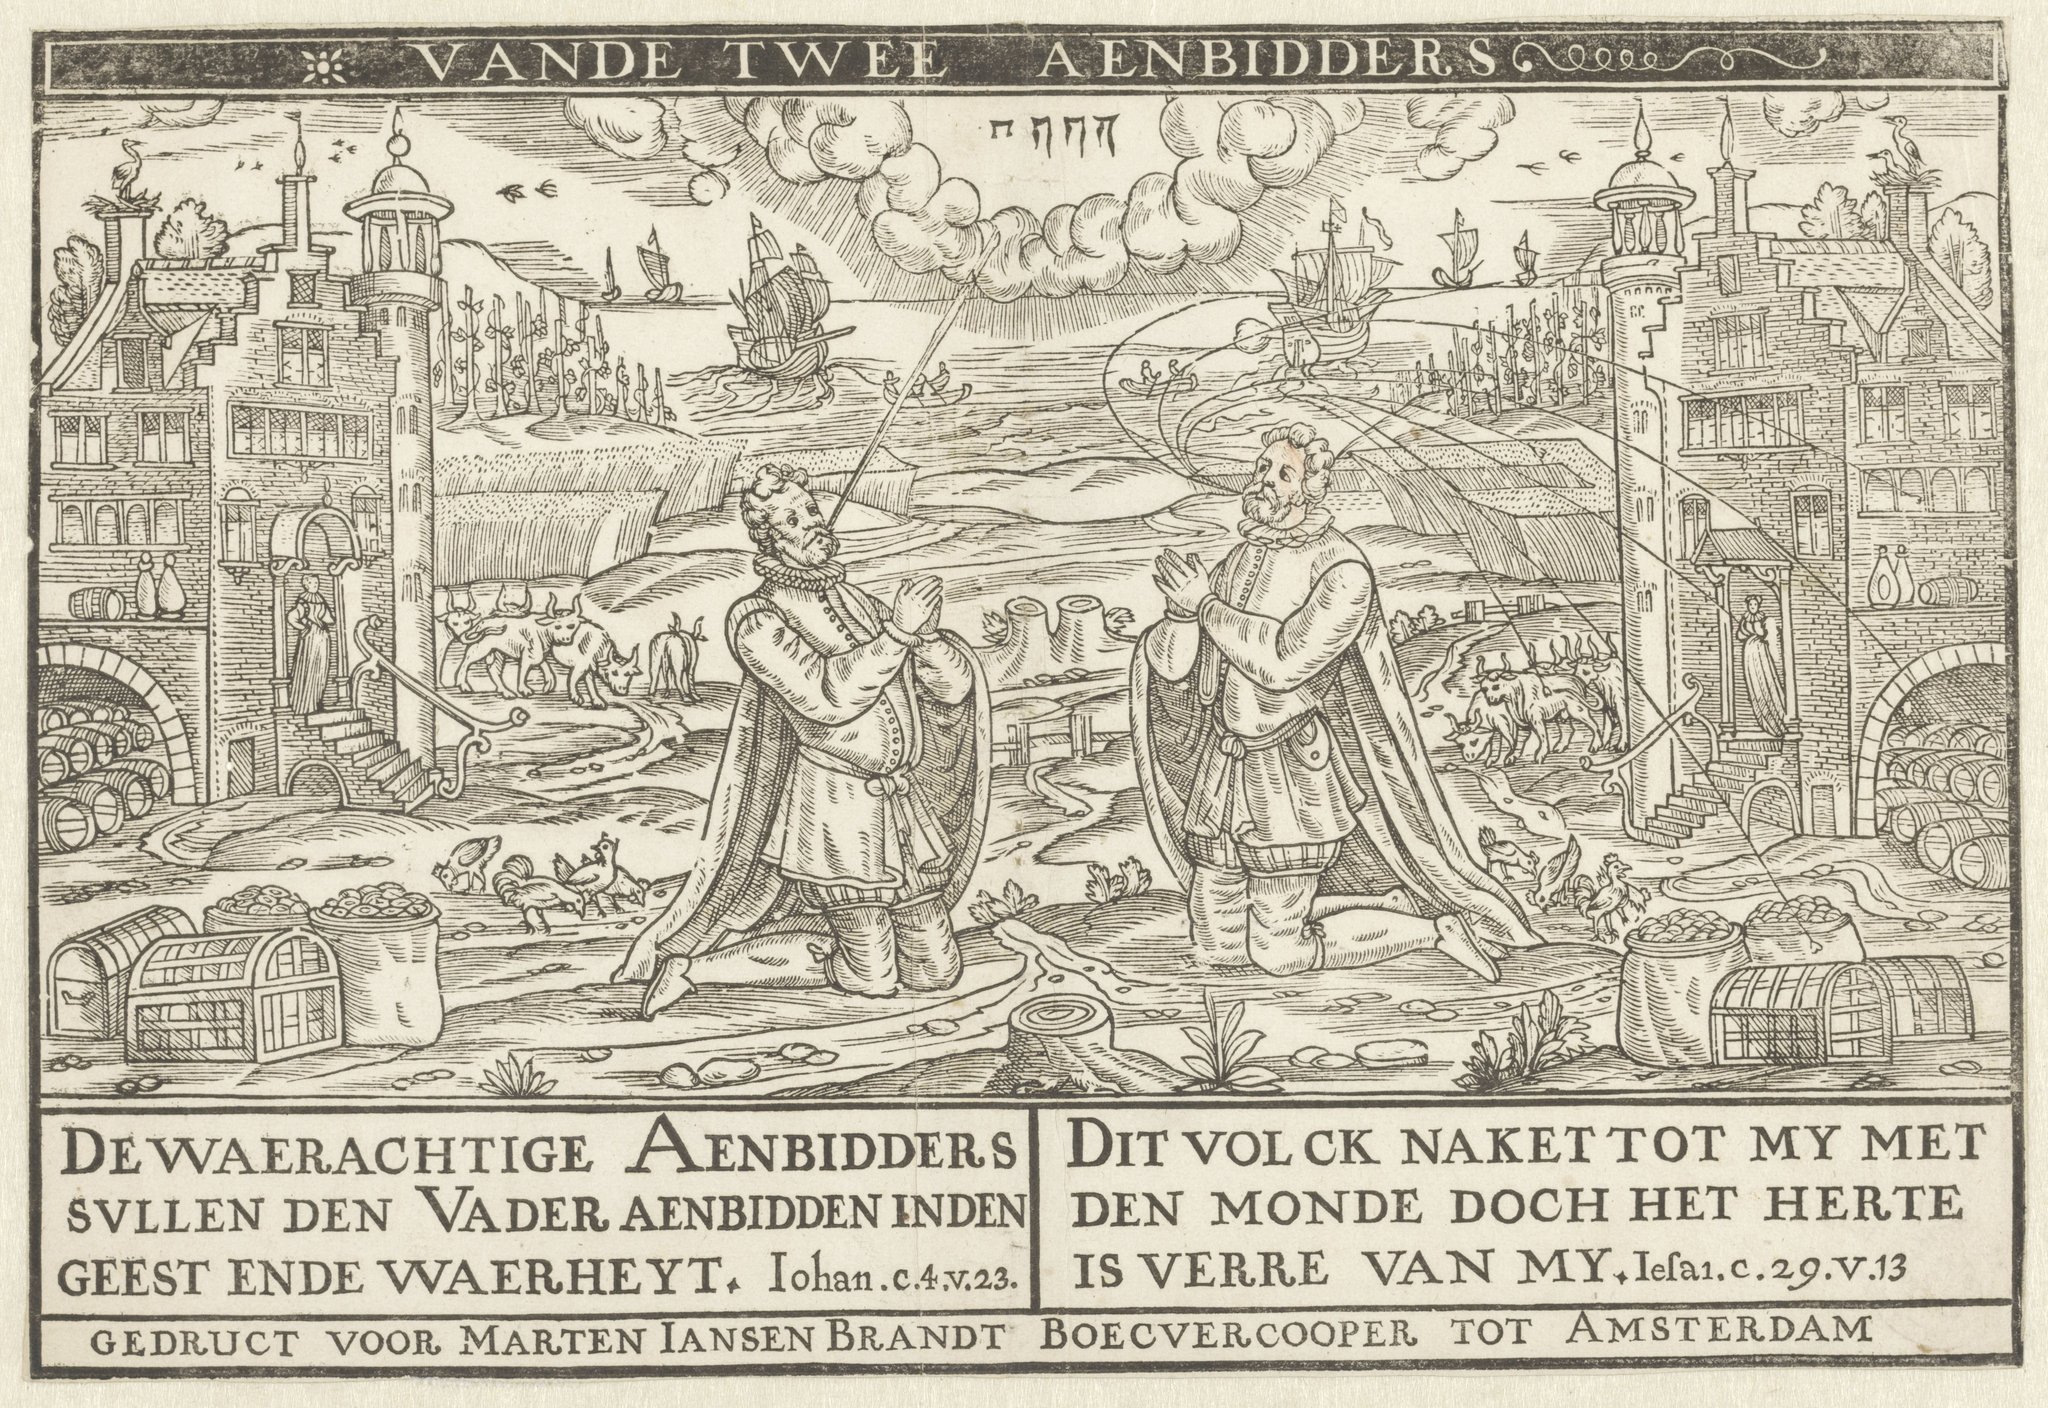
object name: print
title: Vande twee aanbidders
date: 1613-1649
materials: paper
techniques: woodcut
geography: netherlands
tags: the worship of god, kneeling on both knees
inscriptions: collector's mark: Lugt 240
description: Twee knielende mannen naast elkaar in gebed. Op de achtergrond links en rechts twee vrijwel identieke voorstellingen met een vrouw in de deuropening van een woning, vee en gewassen op het land en schepen in het water. In twee kaders regels Nederlandse tekst. (Joh. 4:23 en Jes. 29:13)